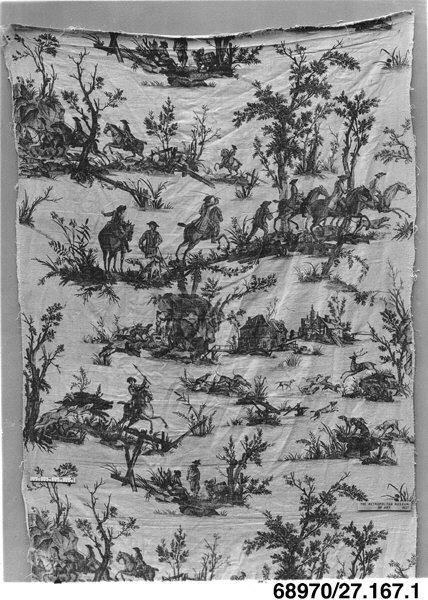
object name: furnishing textile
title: "Hunting Scenes"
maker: oberkampf manufactory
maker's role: manufactory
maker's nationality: french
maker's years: 1760-1843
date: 1780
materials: linen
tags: human figures,hunting,horses,trees